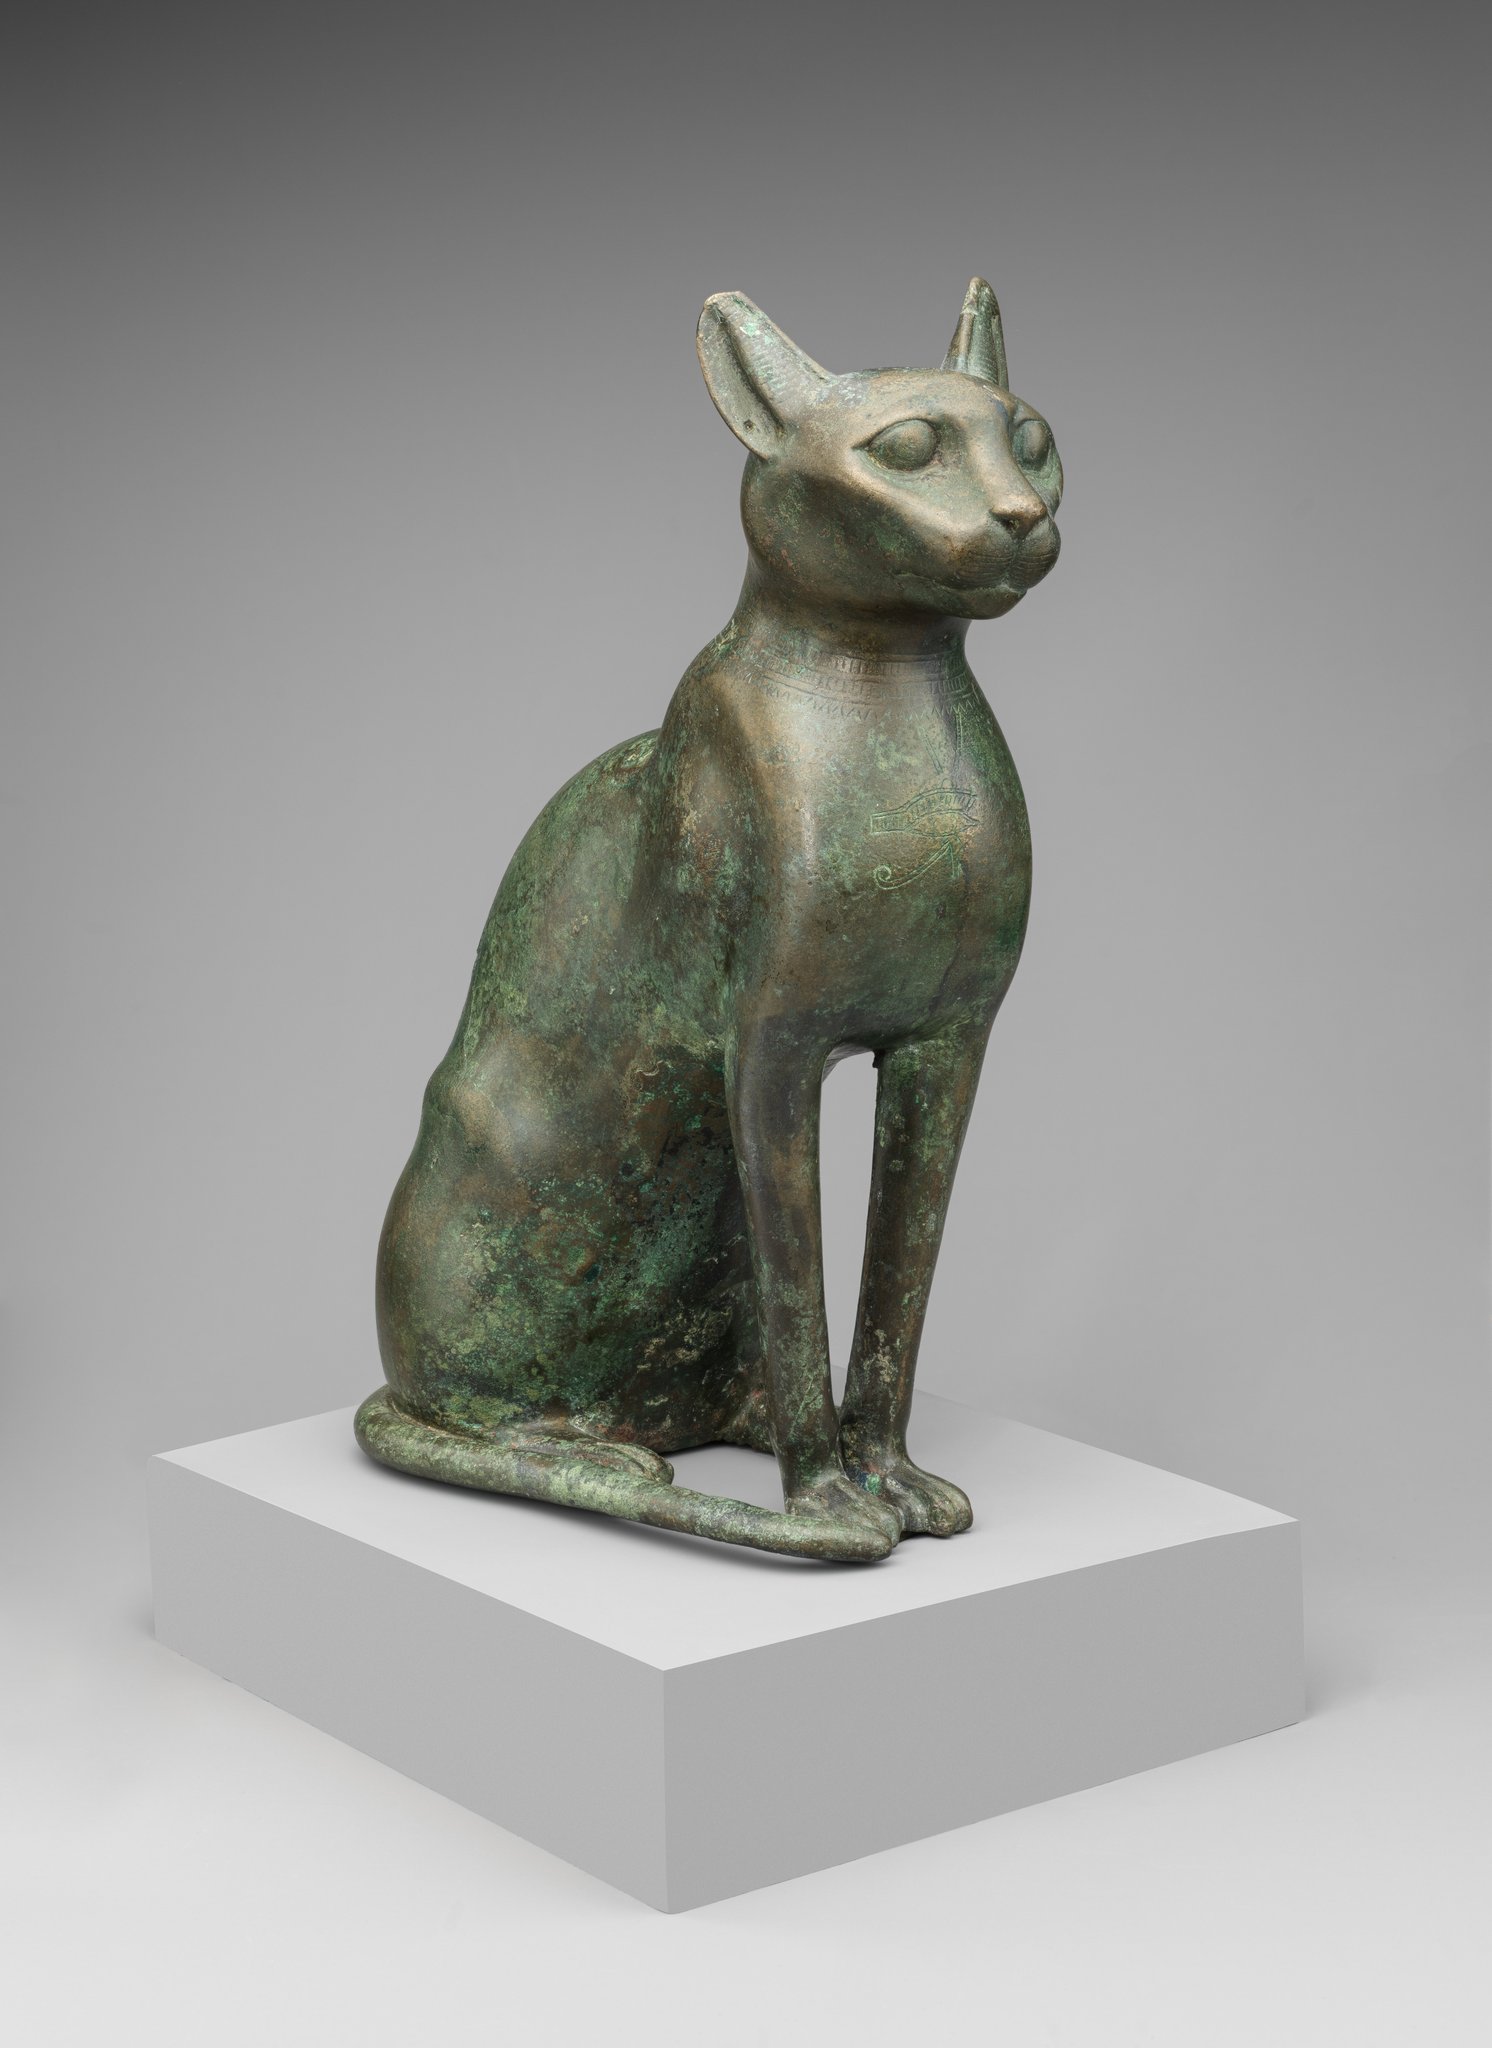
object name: statuette, cat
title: Cat Statuette intended to contain a mummified cat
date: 332-330 BCE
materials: bronze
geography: egypt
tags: cats